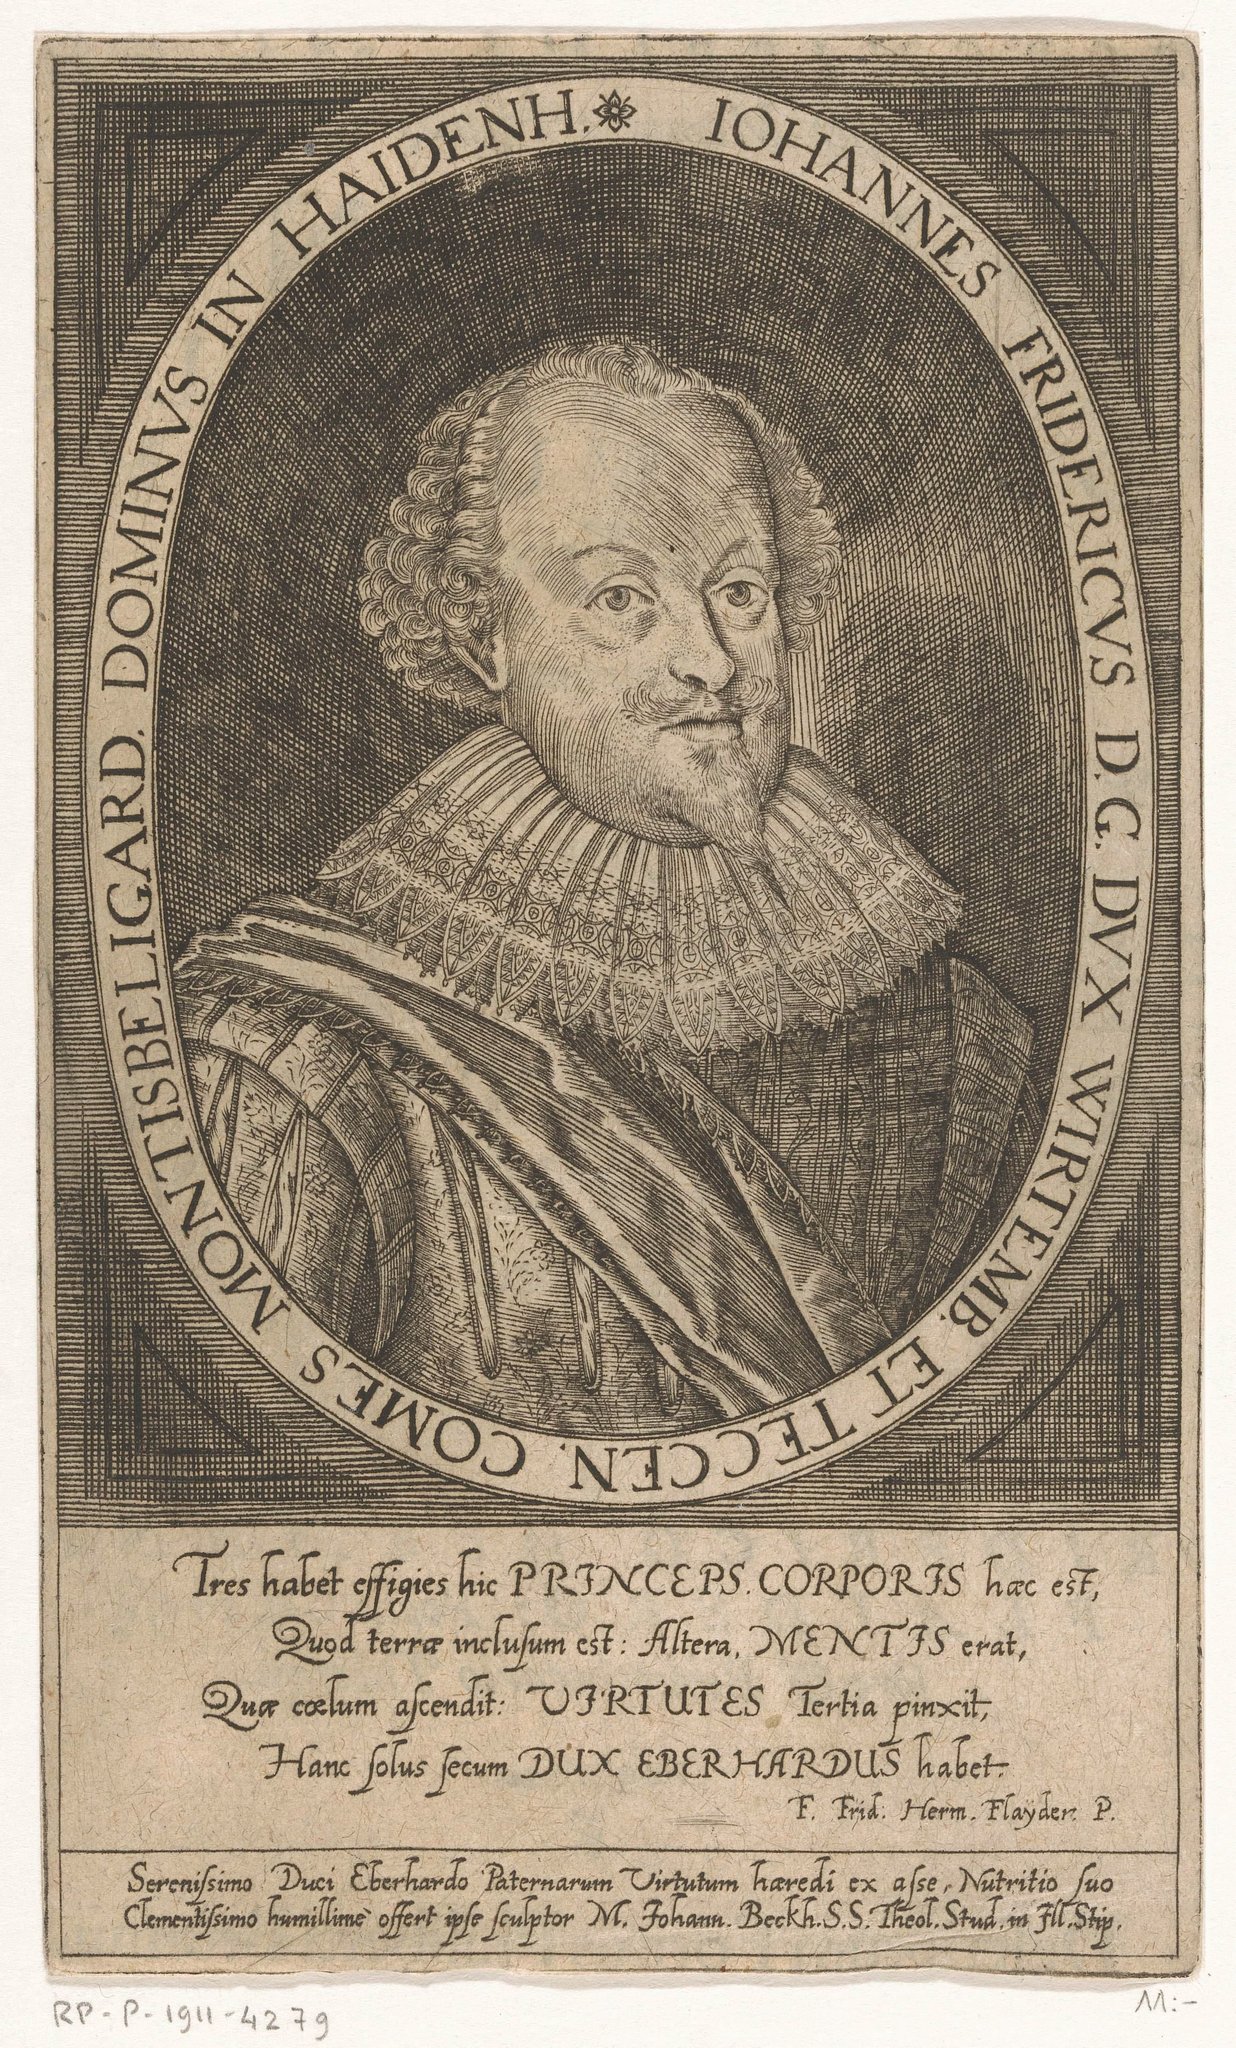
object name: book illustration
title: Portret van Johann Friedrich von Württemberg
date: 1628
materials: paper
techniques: engraving, letterpress printing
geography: tübingen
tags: johann friedrich von württemberg (hertog), historical persons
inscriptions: collector's mark: Lugt 2228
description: Prent afkomstig uit: Flayder, Friedrich Hermann. Funus Serenissimi, Ac Excelsae Memoriae Principis, Johannis Friderici D.G. Ducis Würtembergiae (...). Tübingen: Brunnius, 1628.